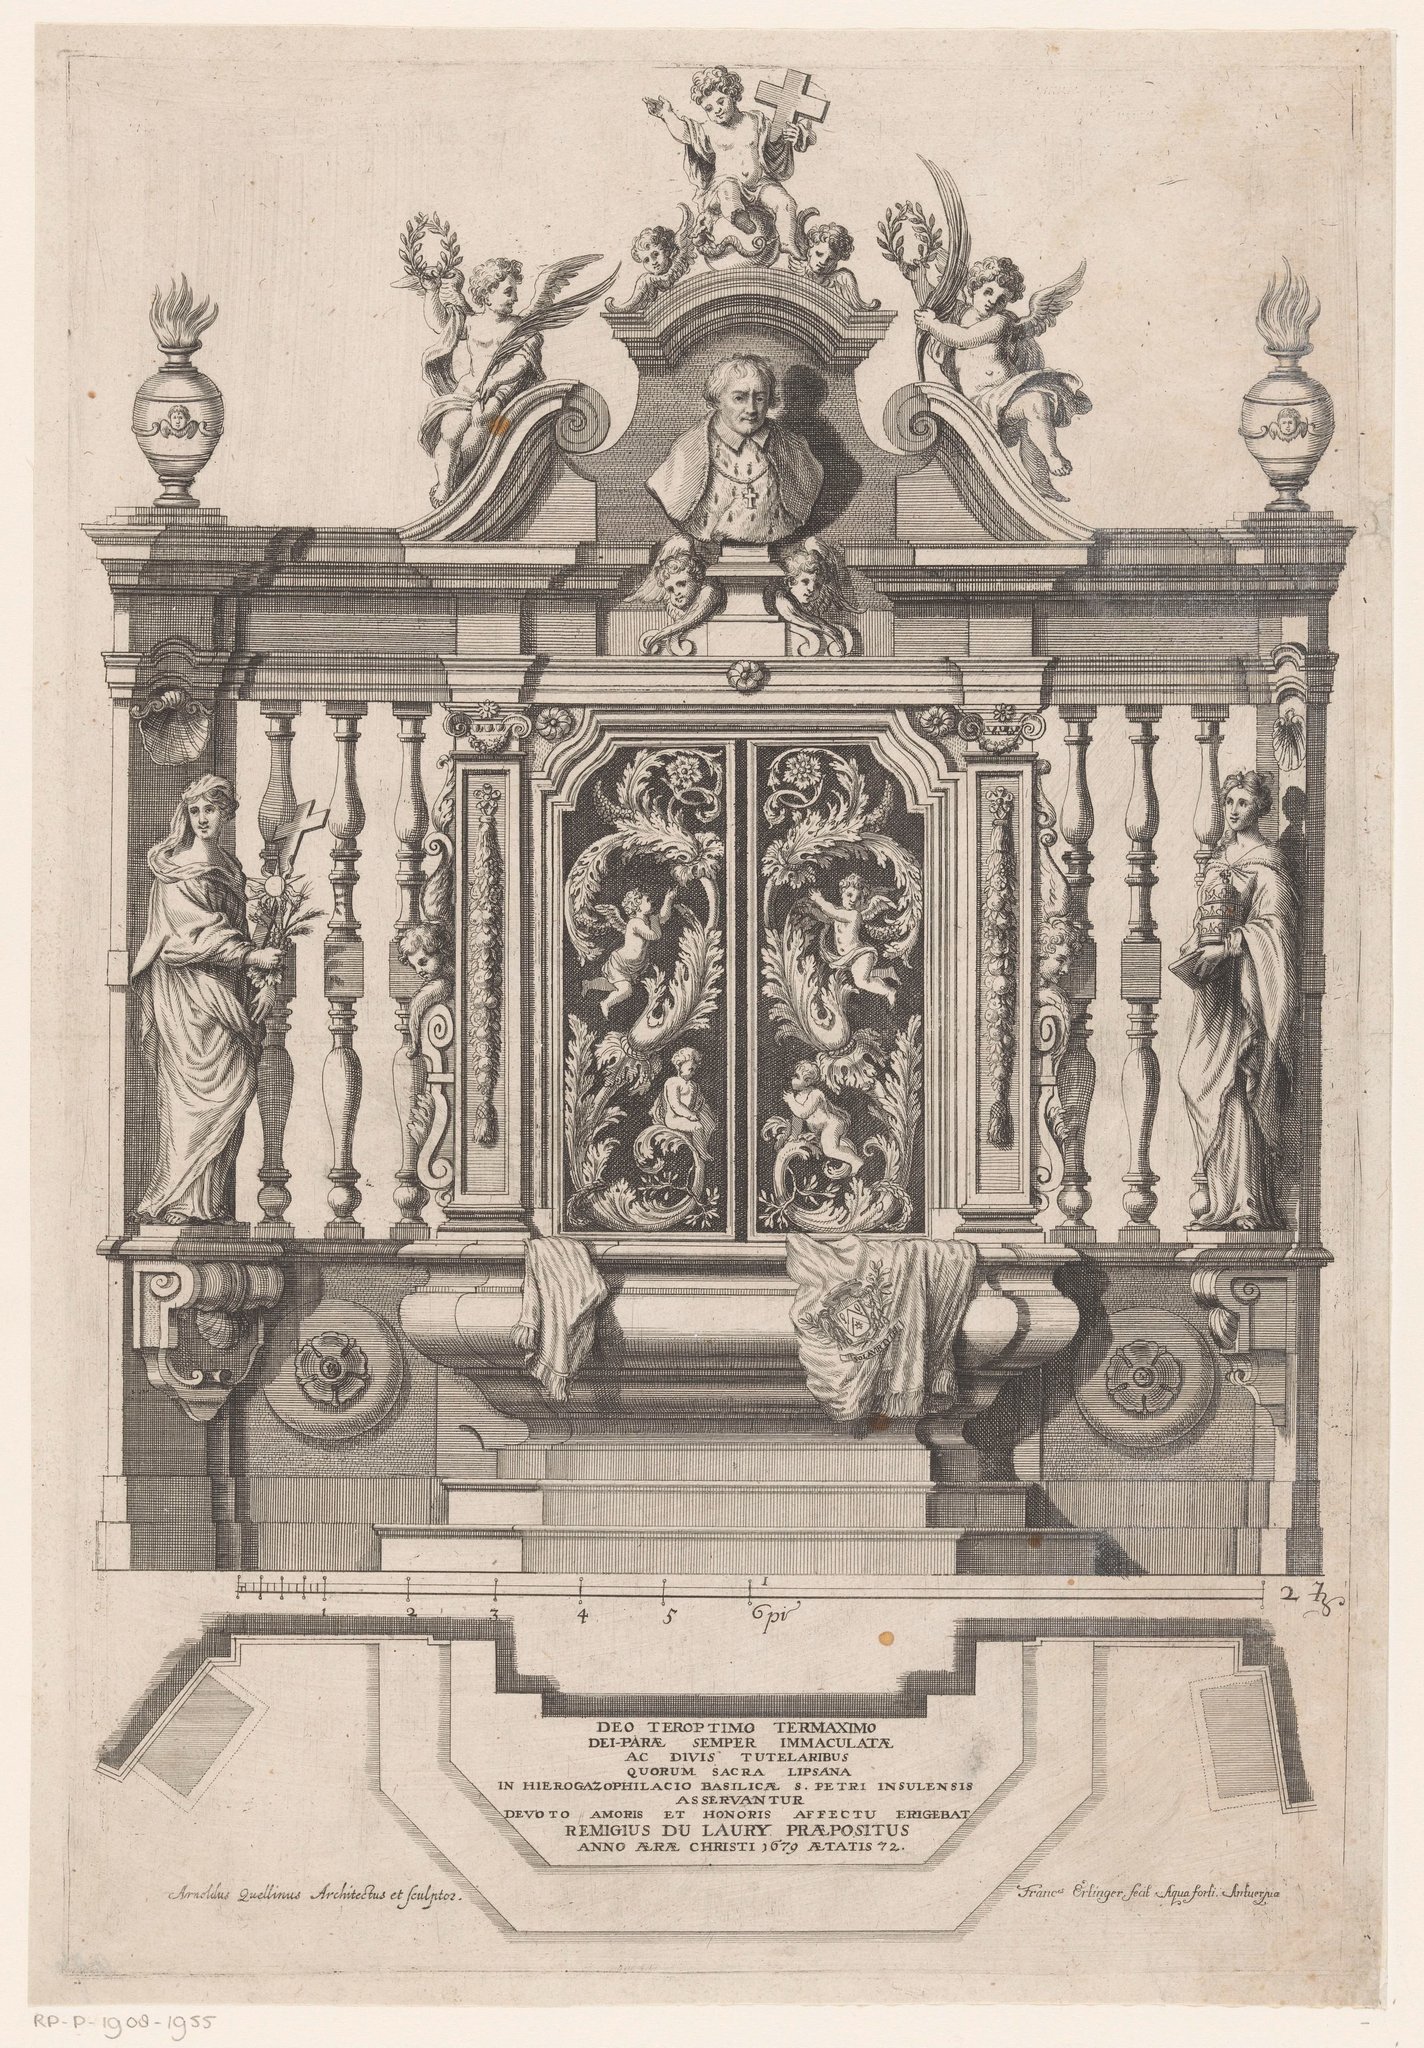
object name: print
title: Grafmonument van Remigius du Laury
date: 1679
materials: paper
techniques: etching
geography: antwerp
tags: historical events and situations; historical persons, grave-building, monumental tomb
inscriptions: collector's mark: Lugt 2228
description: Het grafmonument van Remigius du Laury. Op een verhoging staat een tombe voor twee geornamenteerde deuren met acanthusbladeren en putti. Aan weerszijden balusters en twee personificaties met een kruis en de pauselijke tiara. Daarboven flankeren twee rookvaten een buste van de overledene. Putti met lauwerkransen, palmtakken en een kruis omringen de buste. Aan de onderzijde een bovenaanzicht van het monument met een negenregelige Latijnse tekst.